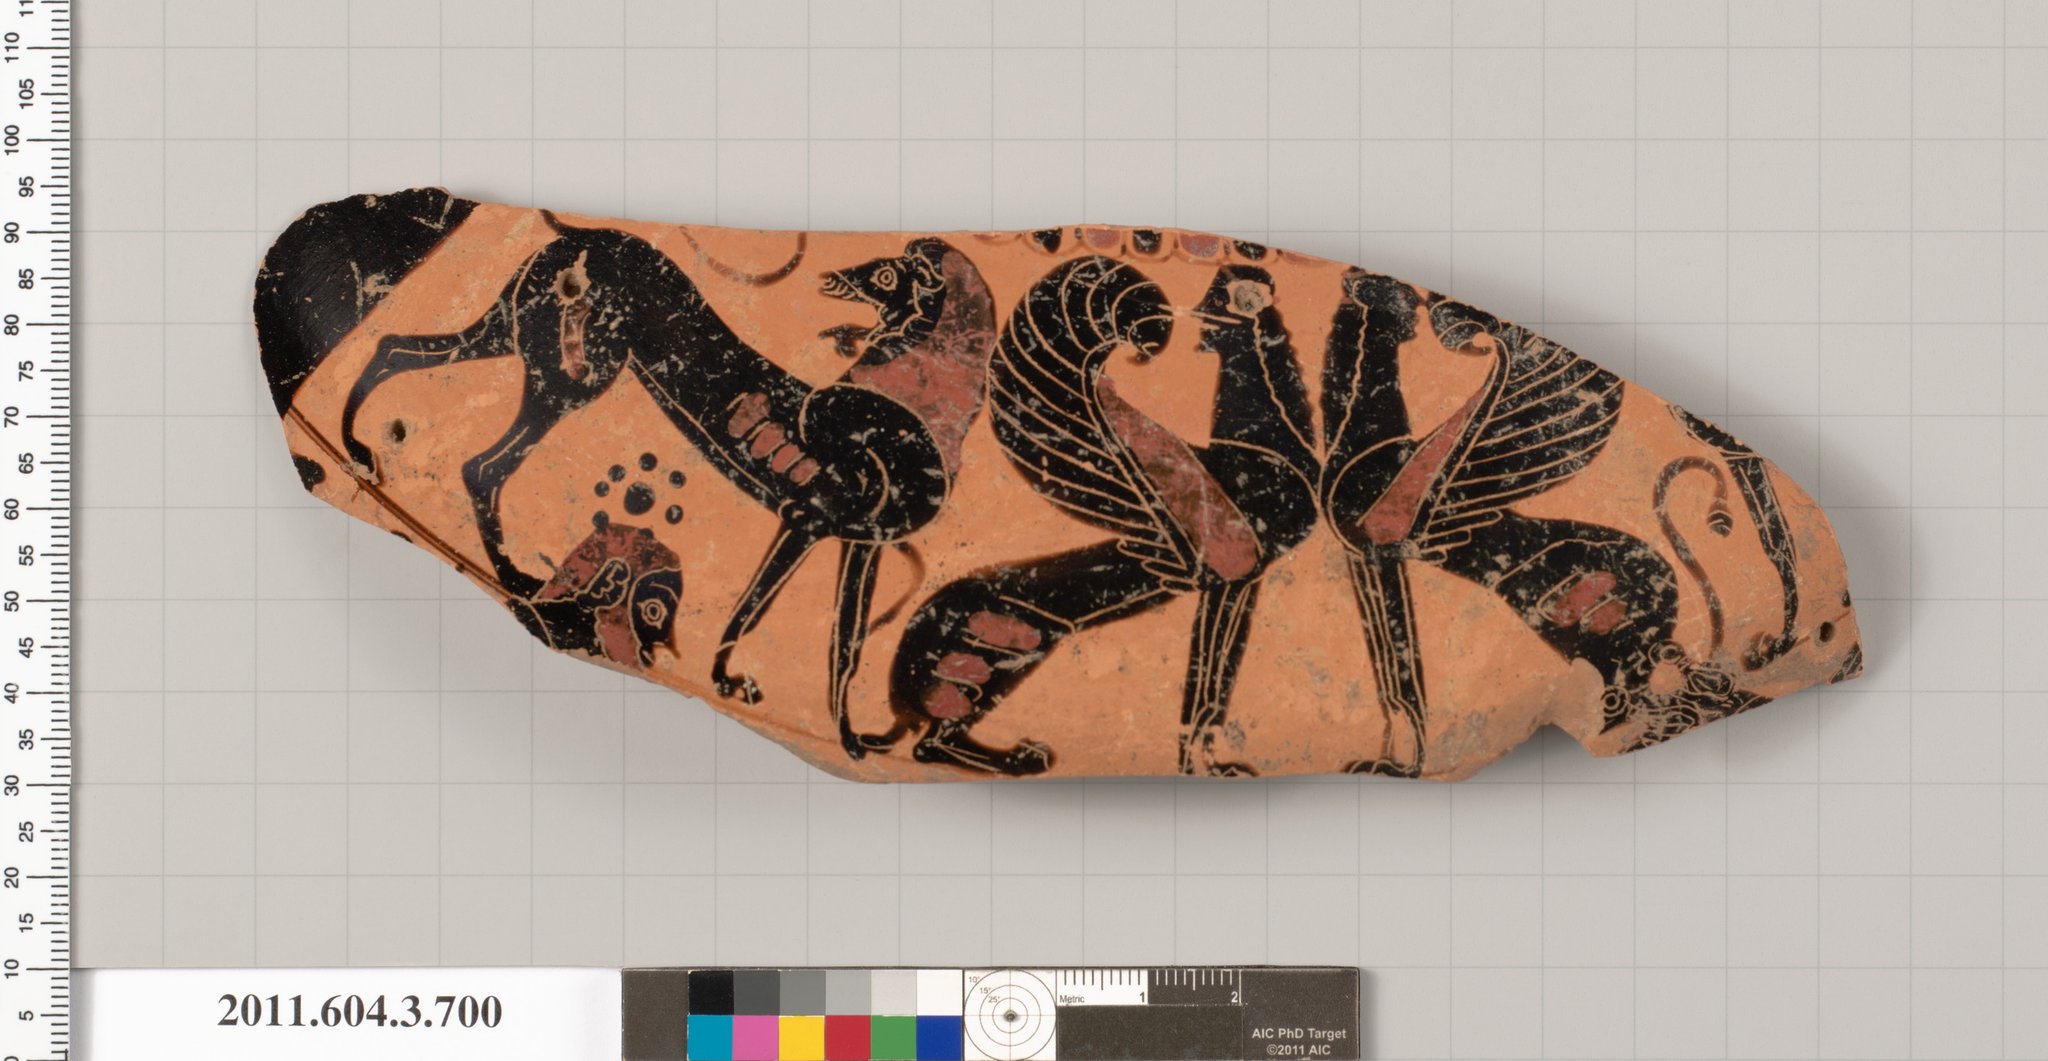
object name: hydria fragment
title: Terracotta fragment of a hydria (water jar)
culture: greek, attic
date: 575-551 BCE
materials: terracotta